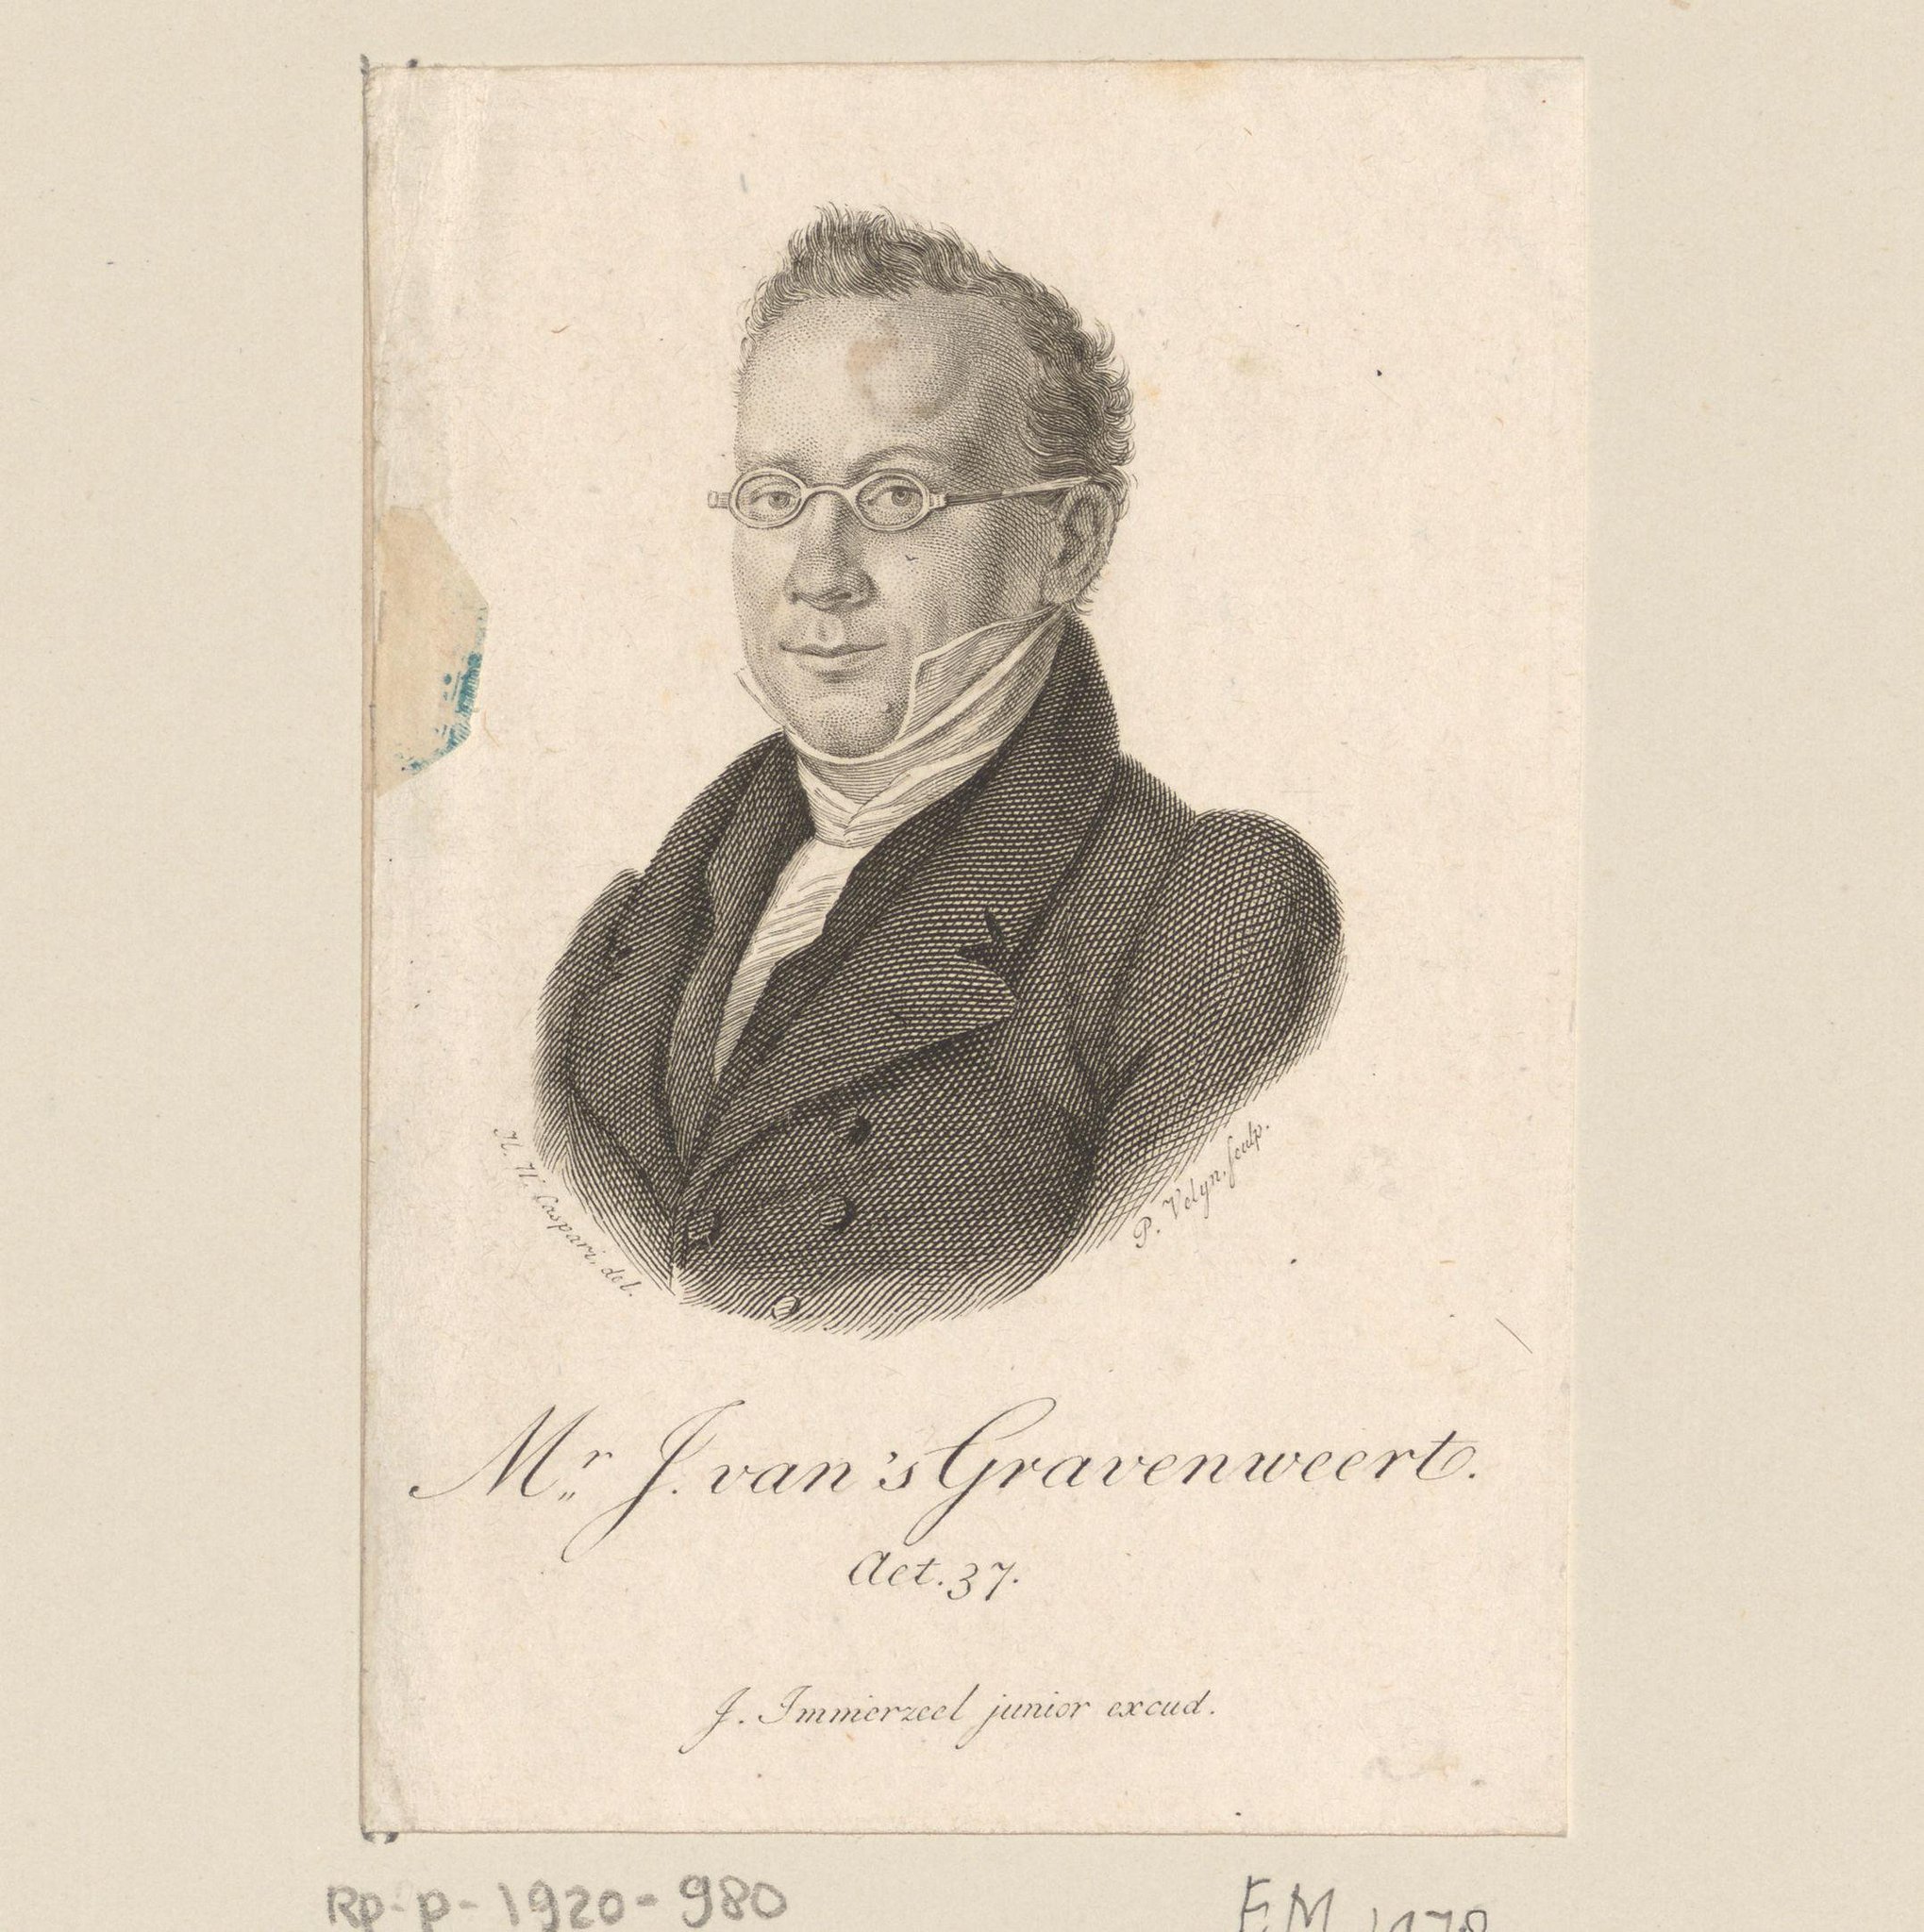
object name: print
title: Portret van Jan van 's Gravenweert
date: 1827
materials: paper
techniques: engraving, etching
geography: amsterdam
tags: amsterdam, eyeglasses, spectacles, historical persons, writer, poet, author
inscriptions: collector's mark: Lugt 2228